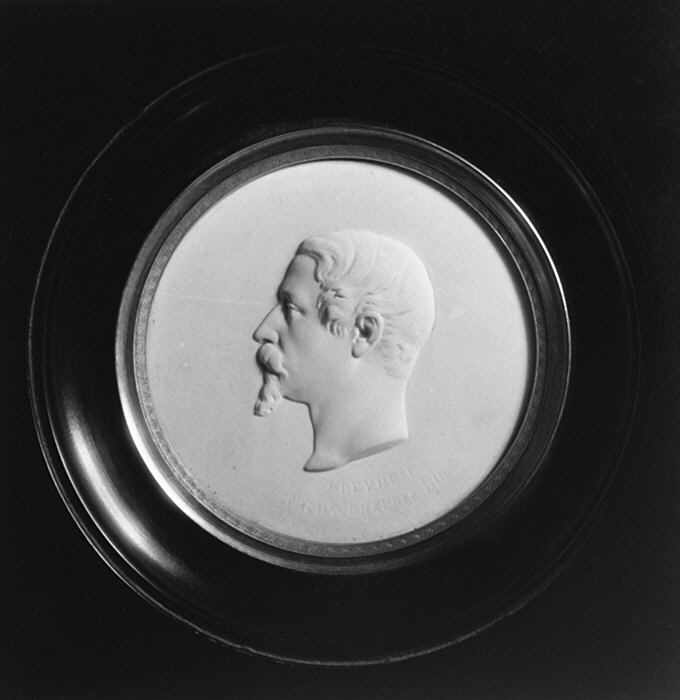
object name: medallion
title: Napoleon III (1808–1873), Emperor of the French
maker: sèvres manufactory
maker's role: manufactory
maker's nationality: french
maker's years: 1740-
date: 1867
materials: biscuit, porcelain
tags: napoleon iii,profiles